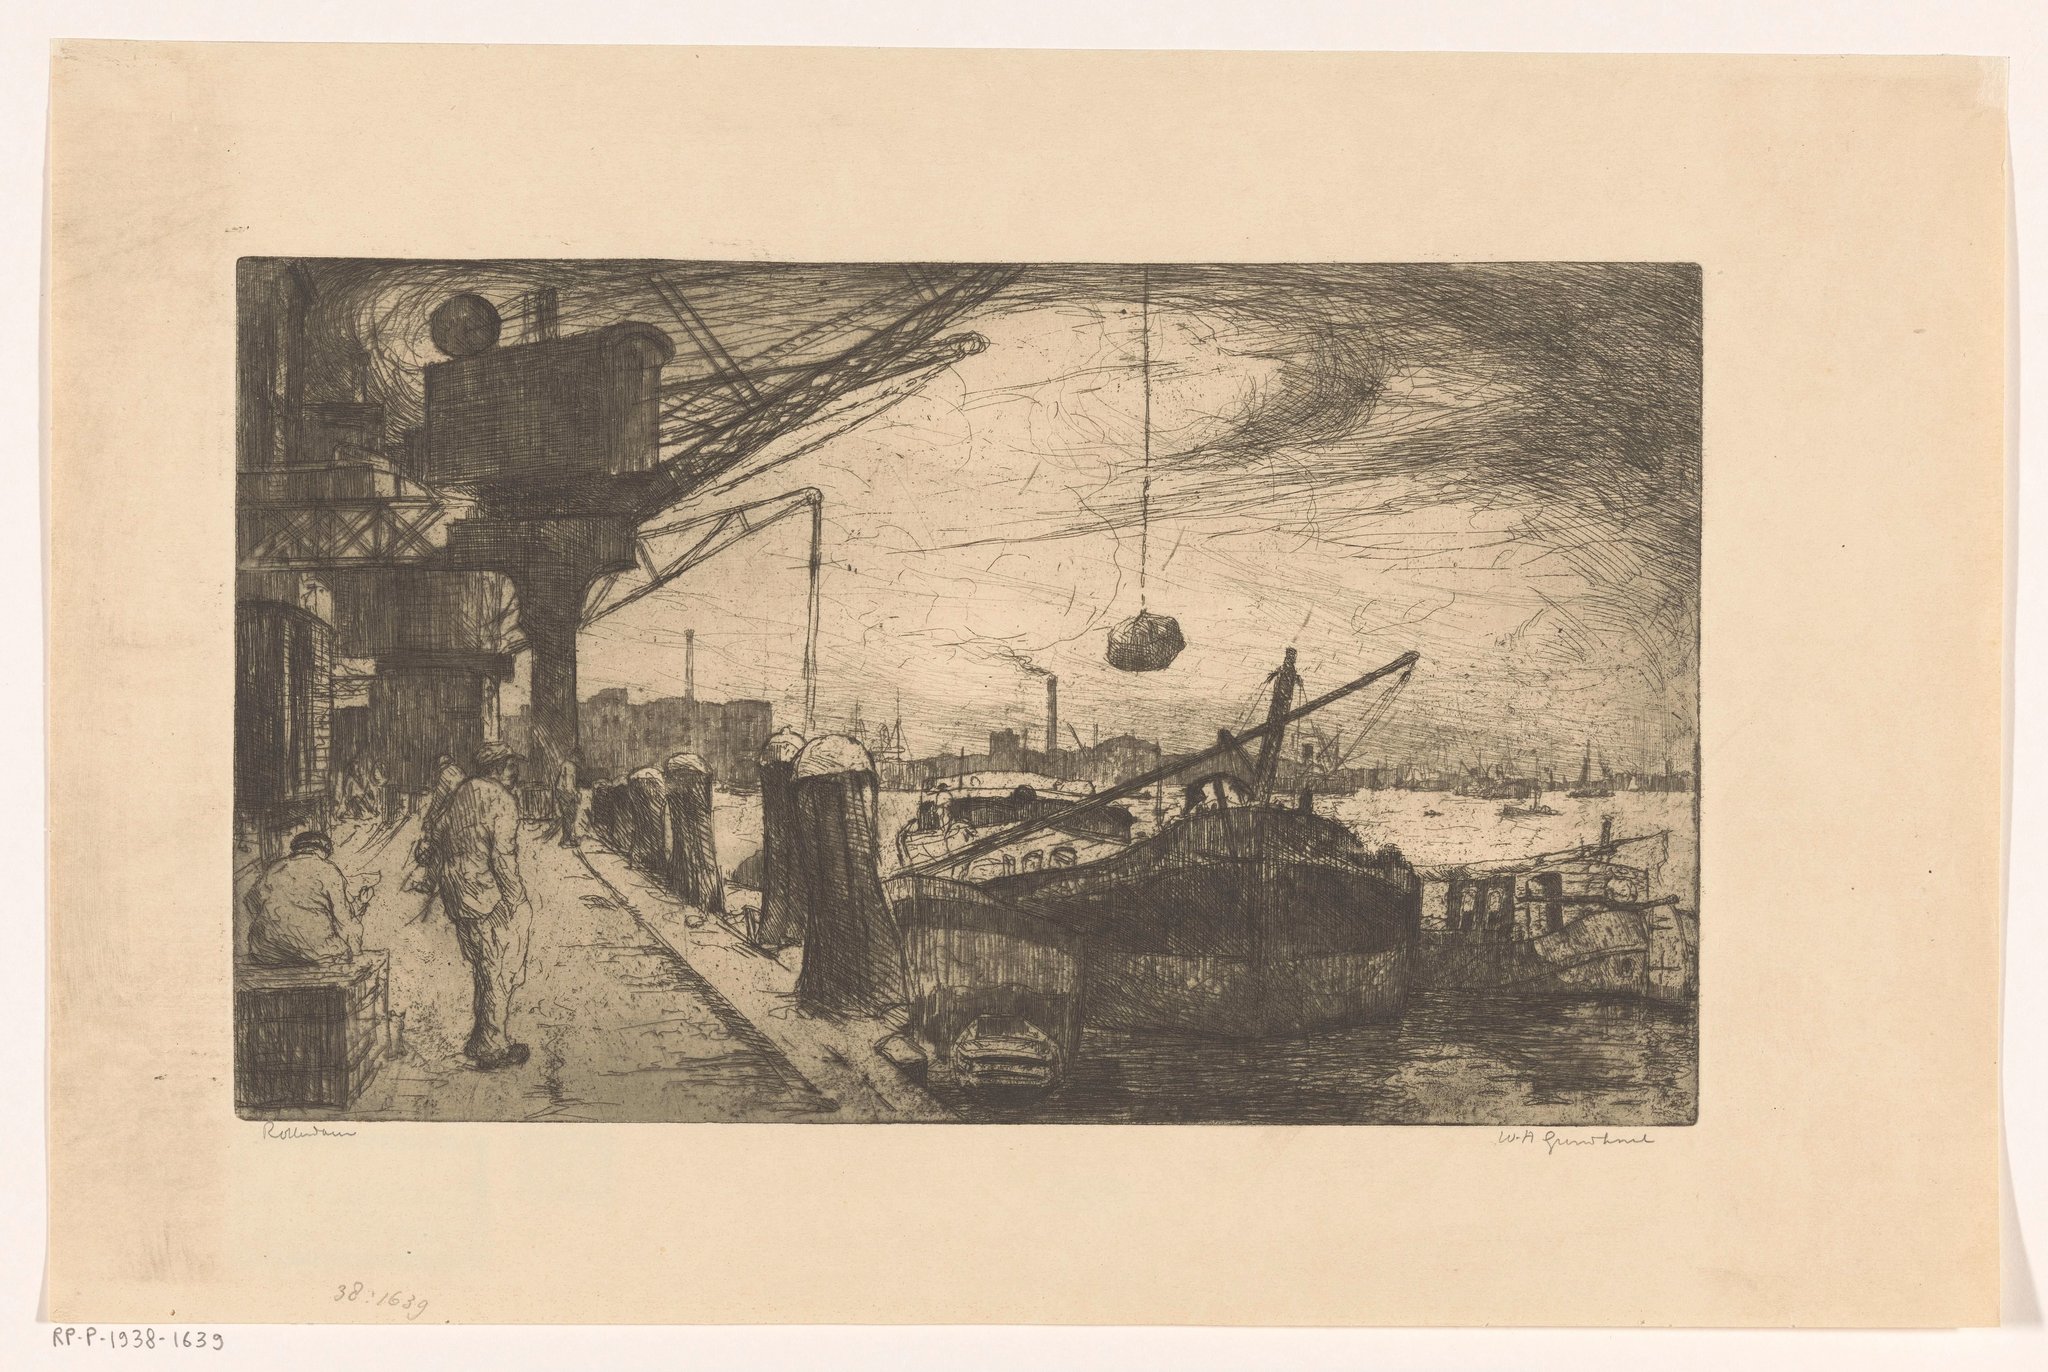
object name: print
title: Rotterdam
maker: willem adrianus grondhout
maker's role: draughtsman, painter, print maker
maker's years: 1878-1934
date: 1888-1934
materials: paper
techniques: etching, intaglio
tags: dock crane, quay, rotterdam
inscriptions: collector's mark: Lugt 2228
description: Links hijskranen en figuren op een havenkade. Rechts afgemeerde schepen.